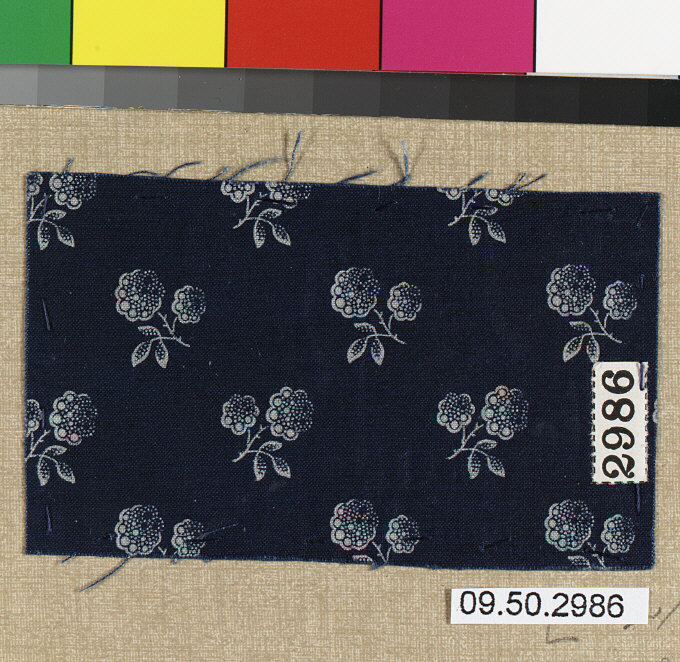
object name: piece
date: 1801-1900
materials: cotton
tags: flowers,leaves